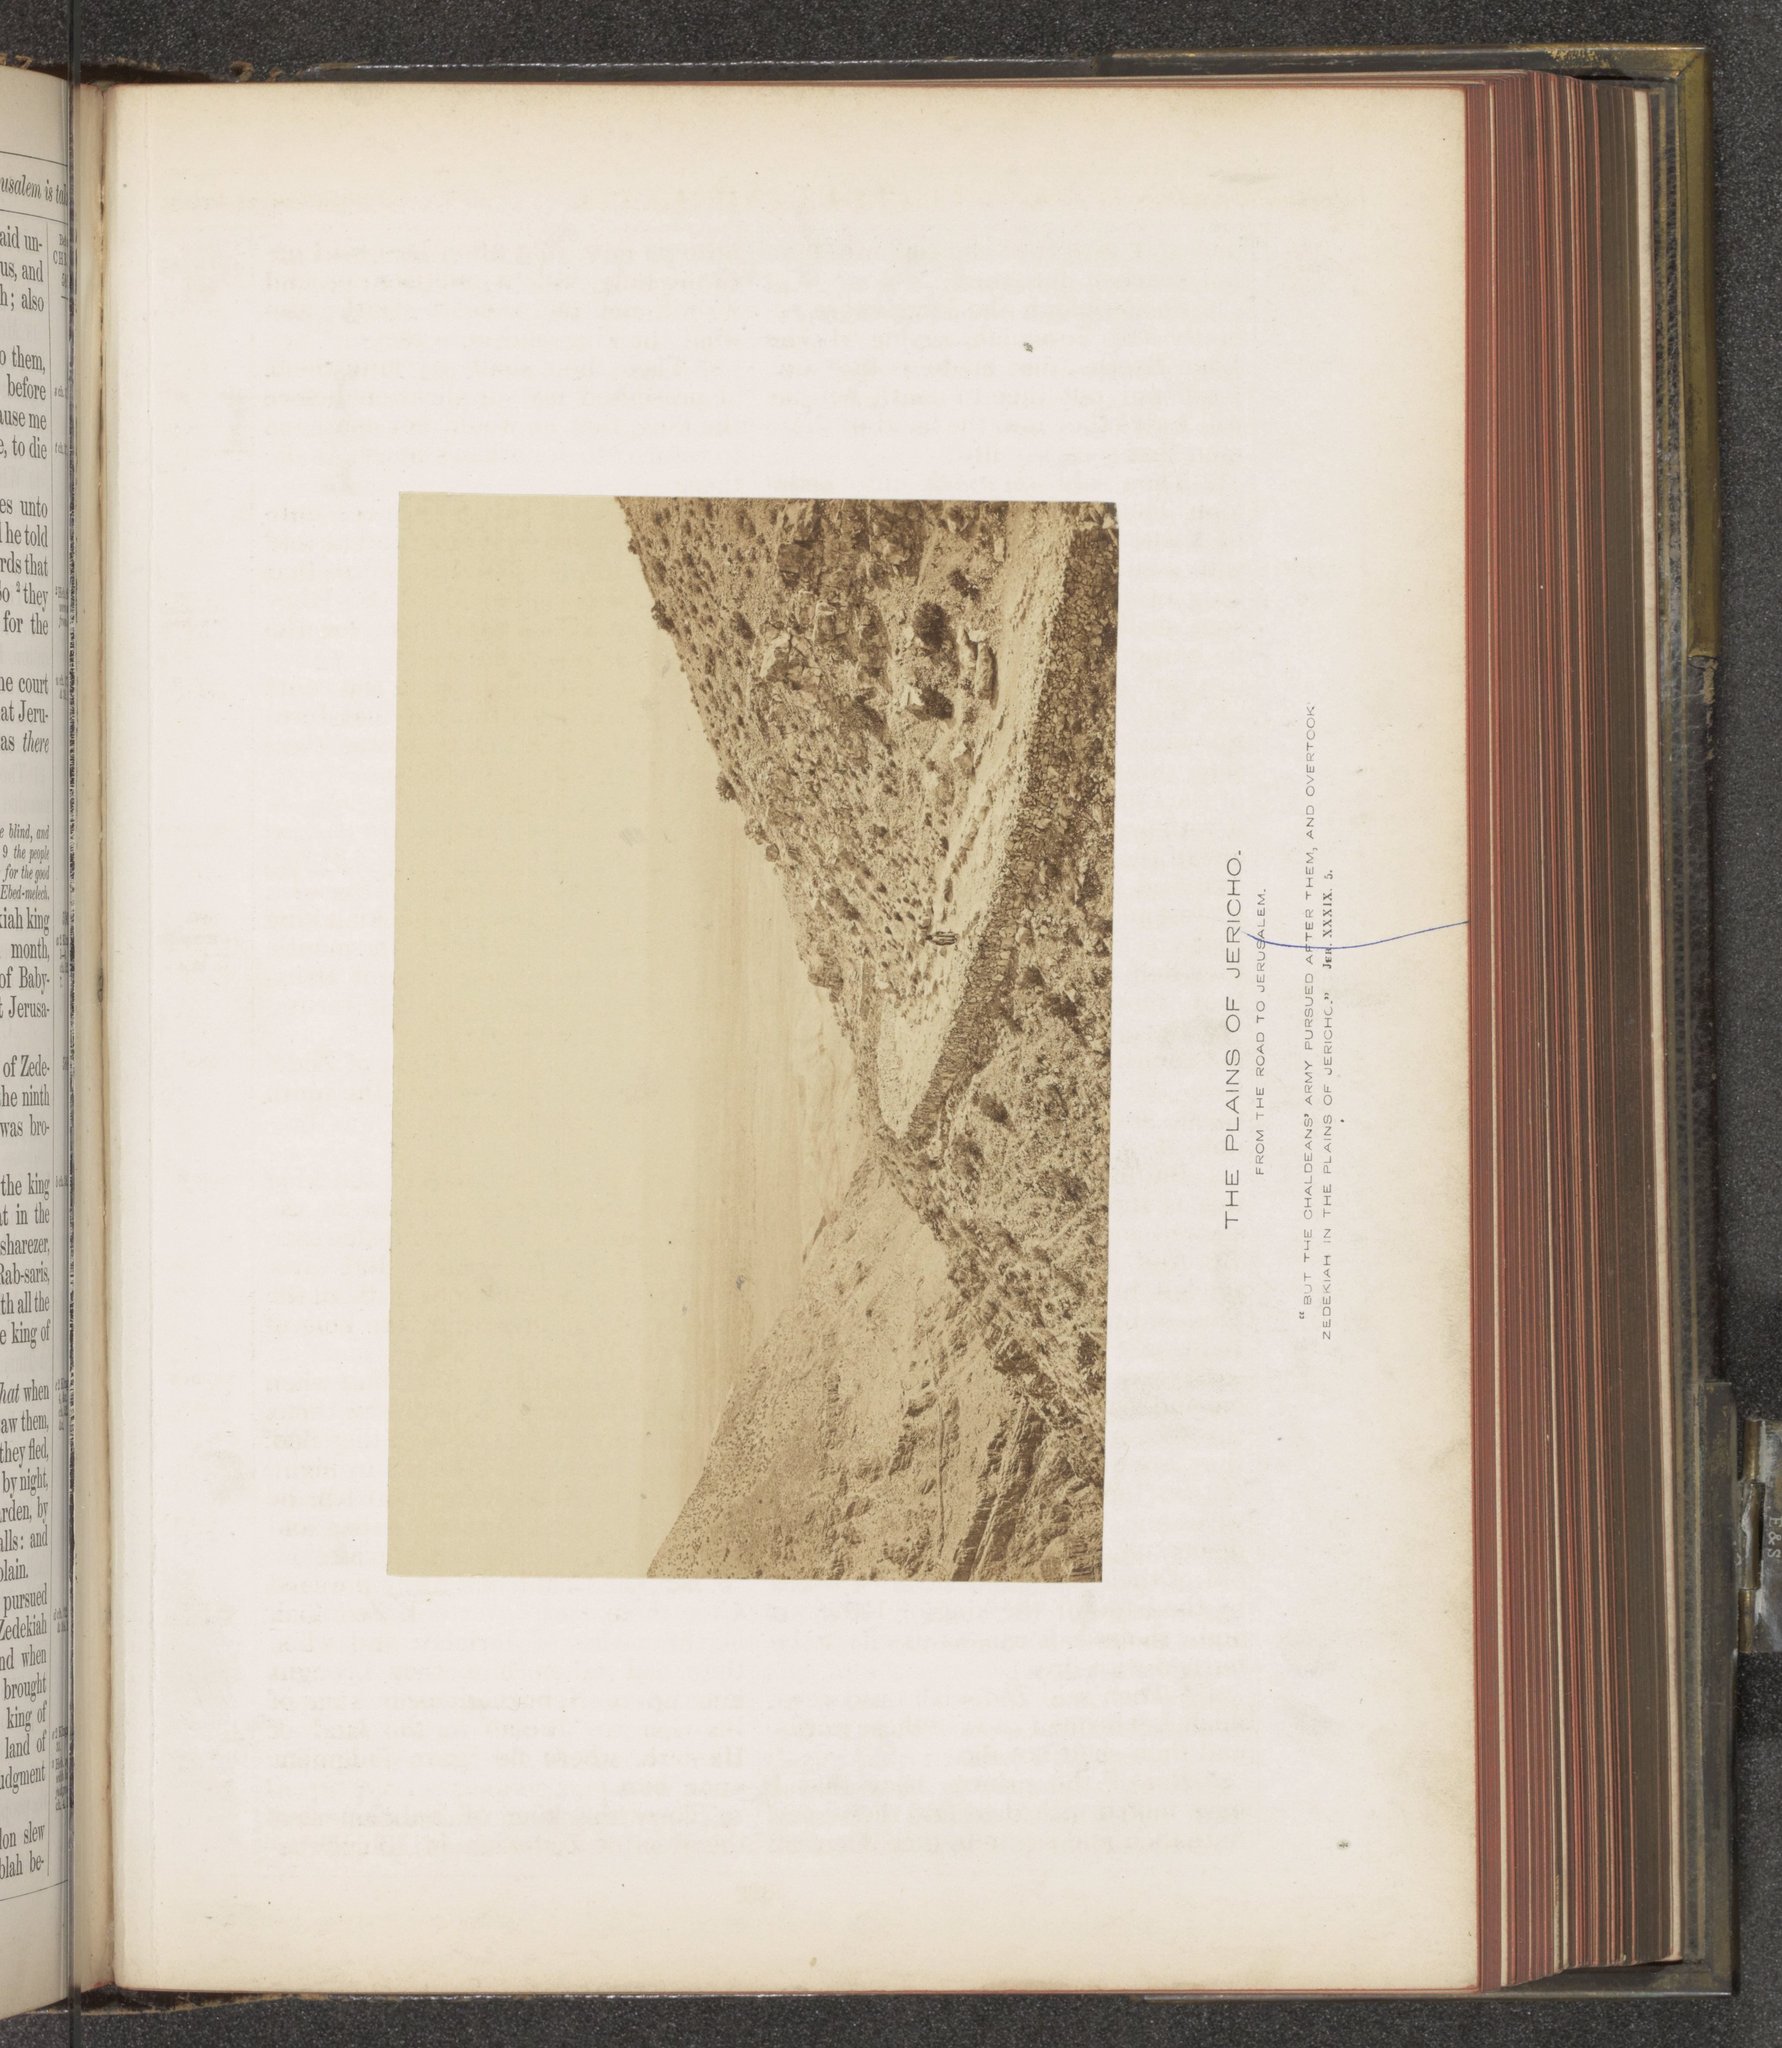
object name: page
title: Landschap bij Jericho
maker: francis frith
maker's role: publisher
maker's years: 1822-1898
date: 1850-1865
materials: photographic support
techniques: albumen print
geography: jericho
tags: desert - kk - ideal landscapes, mountains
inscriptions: inscription: ‘"But the chaldeans' army pursued after them, and overtook Zedekiah in the plains of Jericho." Jer XXXiX. 5.’